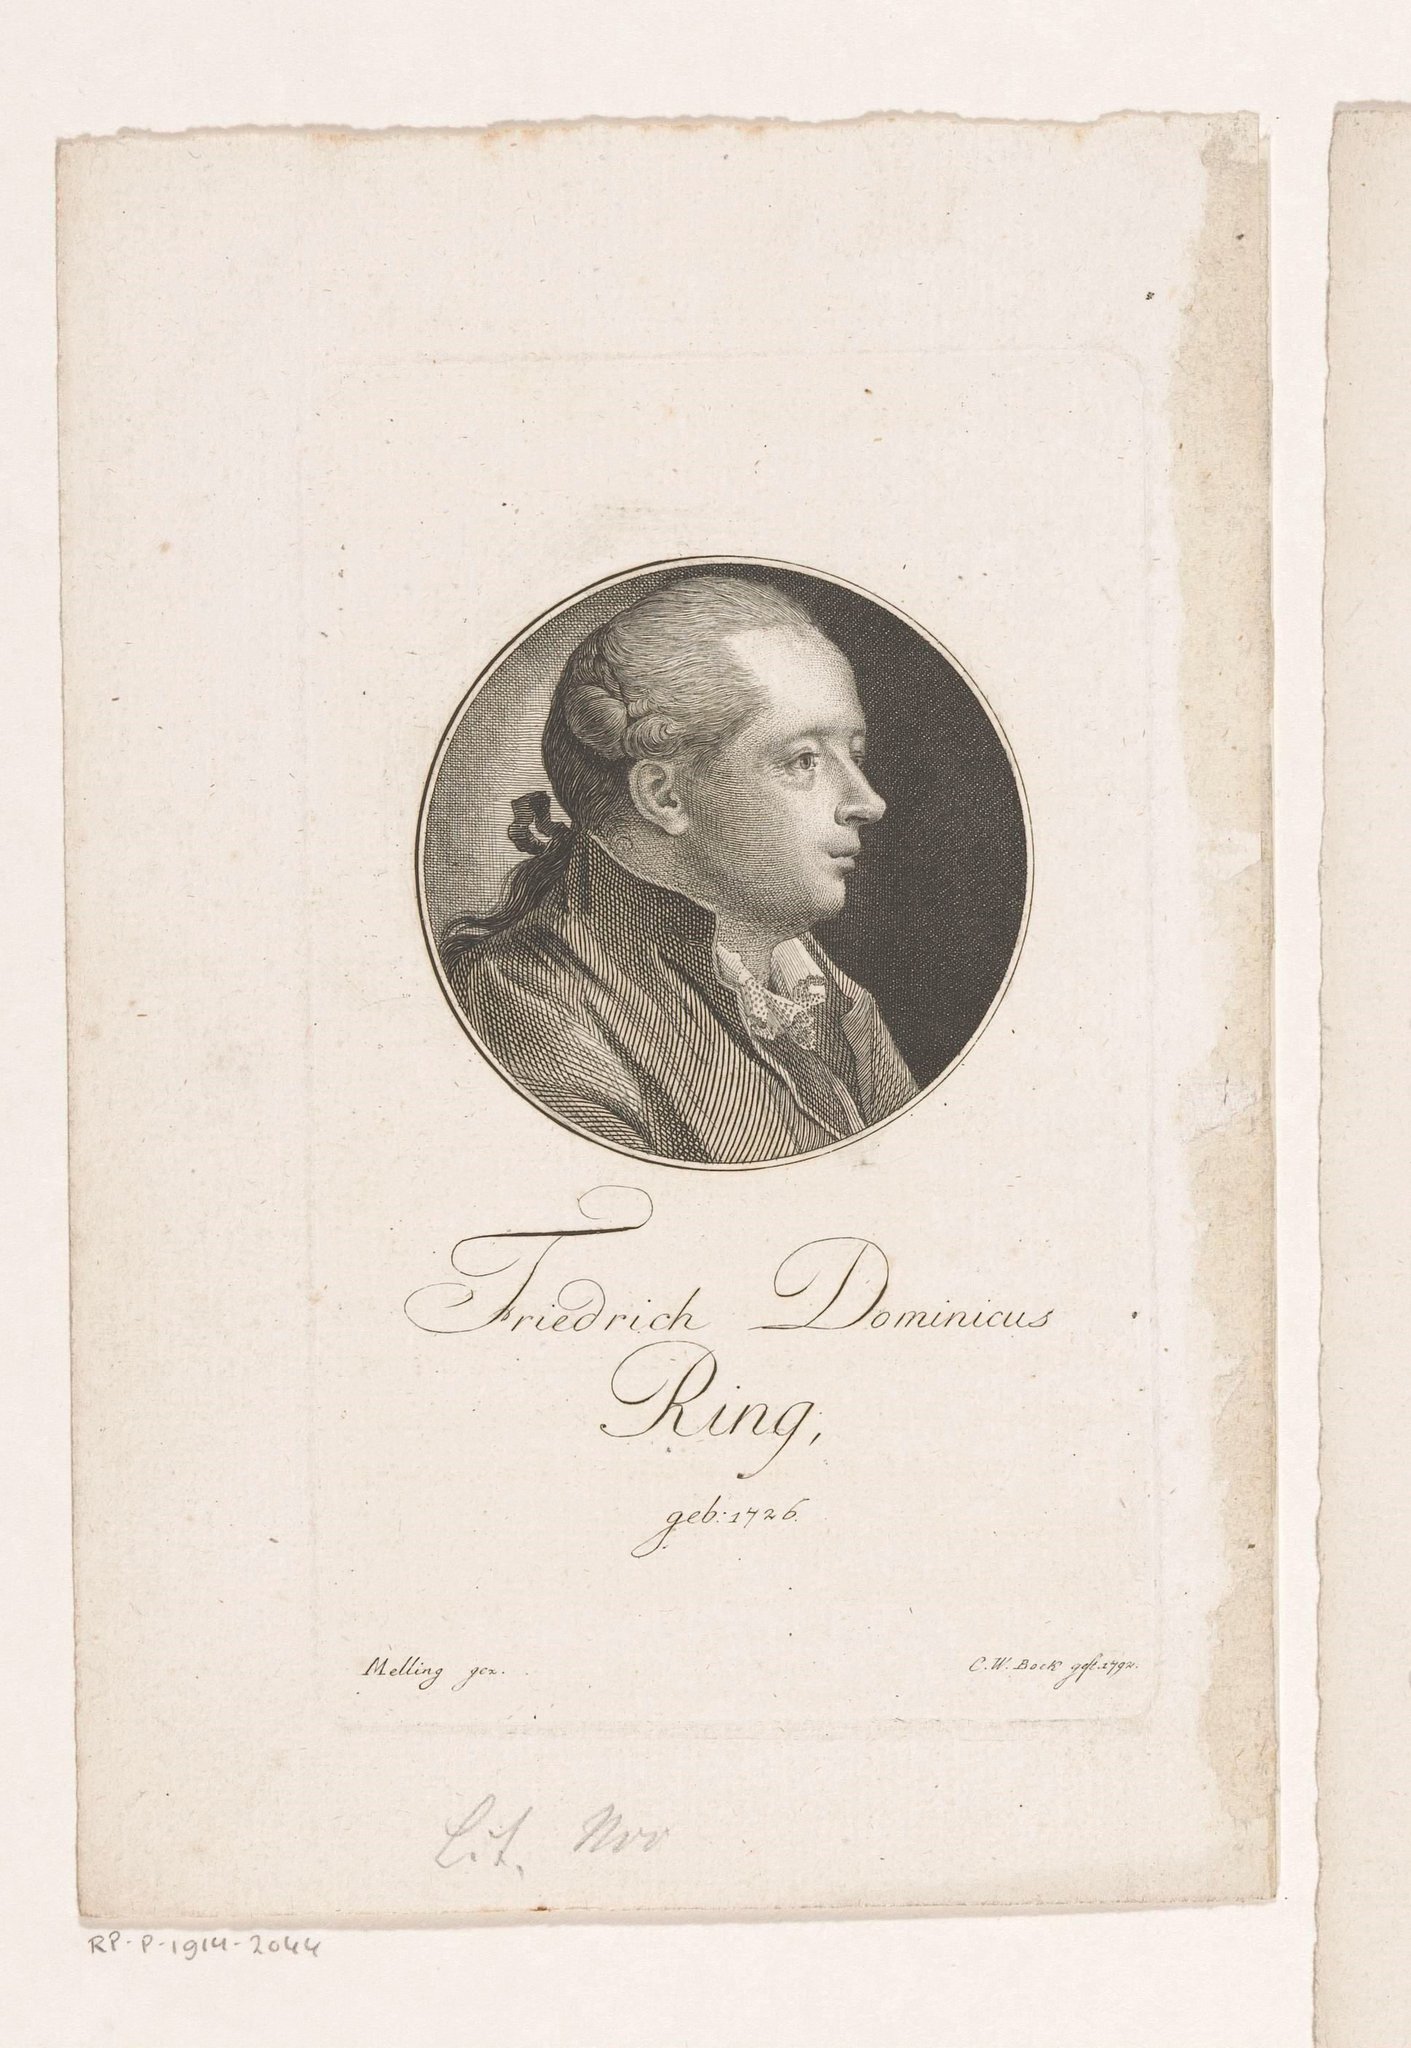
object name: print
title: Portret van Friedrich Dominicus Ring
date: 1792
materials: paper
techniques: engraving, etching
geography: nuremberg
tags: historical persons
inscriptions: collector's mark: Lugt 2228